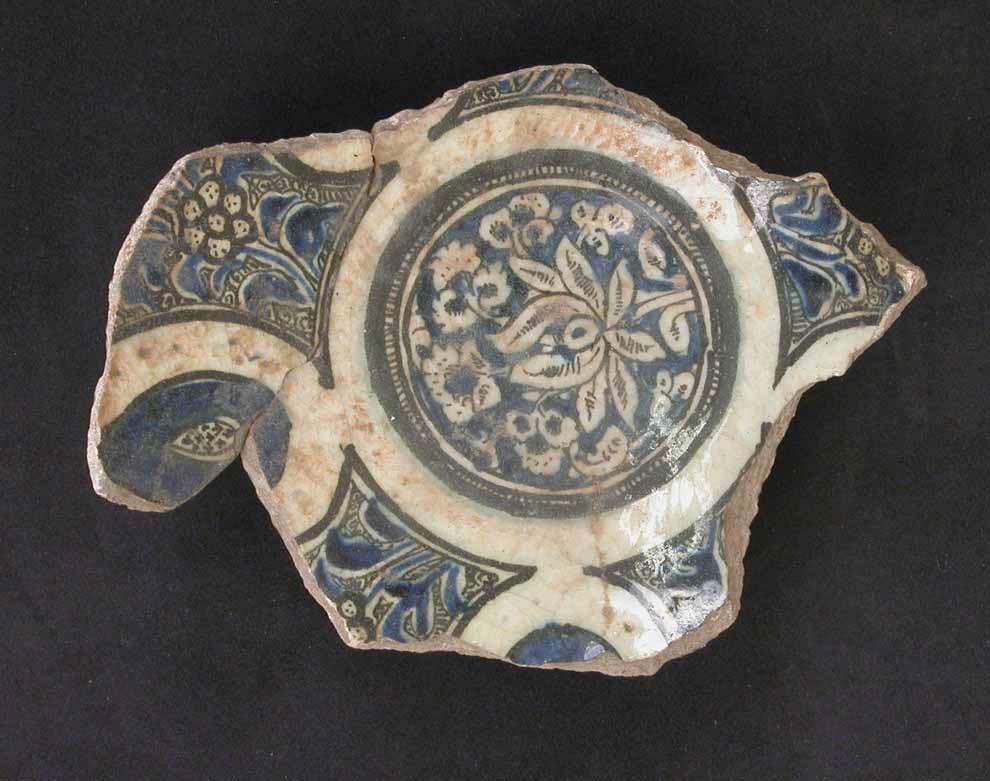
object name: fragment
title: Fragment of a Bowl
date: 1301-1400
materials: glaze, stonepaste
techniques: underglaze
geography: syria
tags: flowers